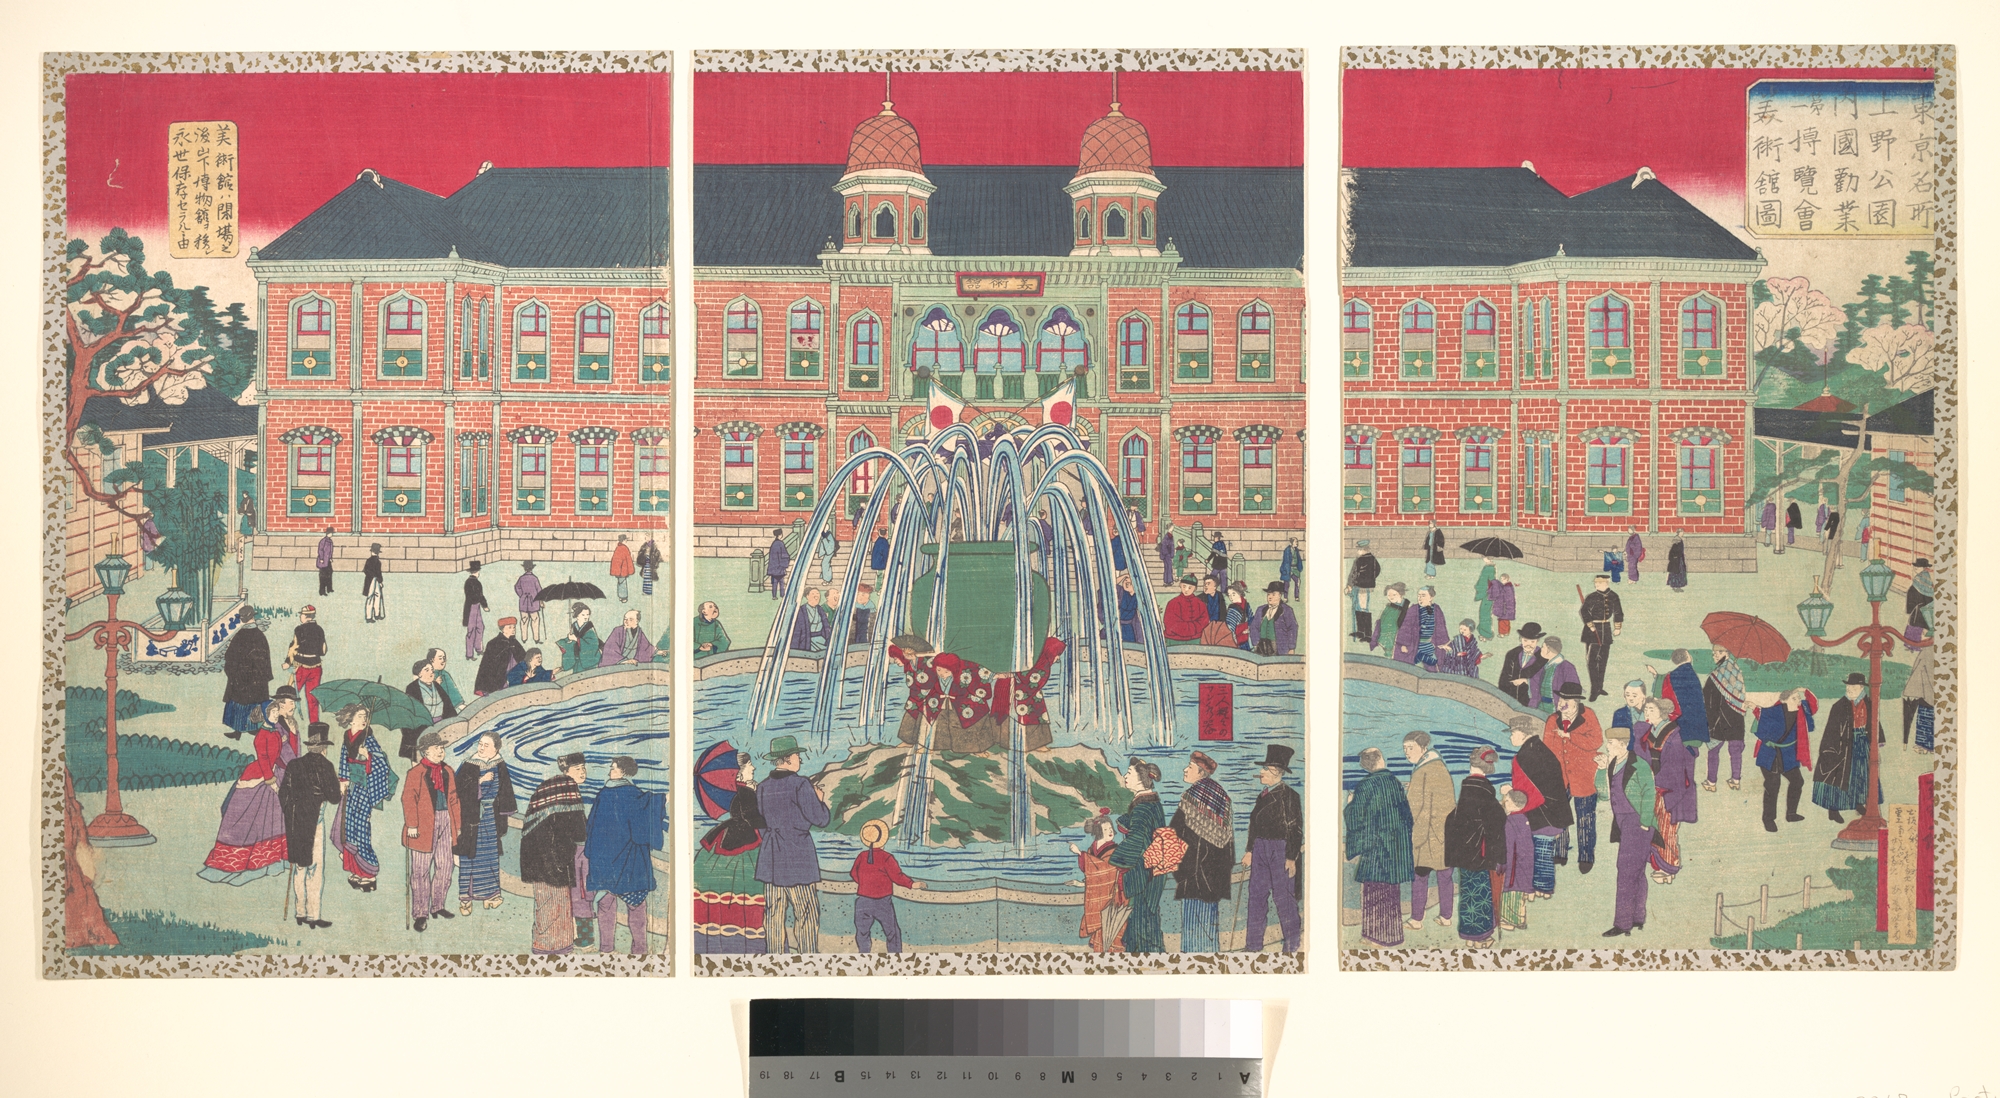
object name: print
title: Illustration of the Museum at the Second National Industrial Exhibition in Ueno, from the series Famous Places in Tokyo (Tokyo meisho-Ueno kōen naikoku kangyō daini hakurankai bijutsukan zu)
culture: japanese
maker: utagawa hiroshige iii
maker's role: artist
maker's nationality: japanese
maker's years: 1843-1894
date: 1881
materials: ink, paper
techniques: woodblock print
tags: buildings,fountains,men,women